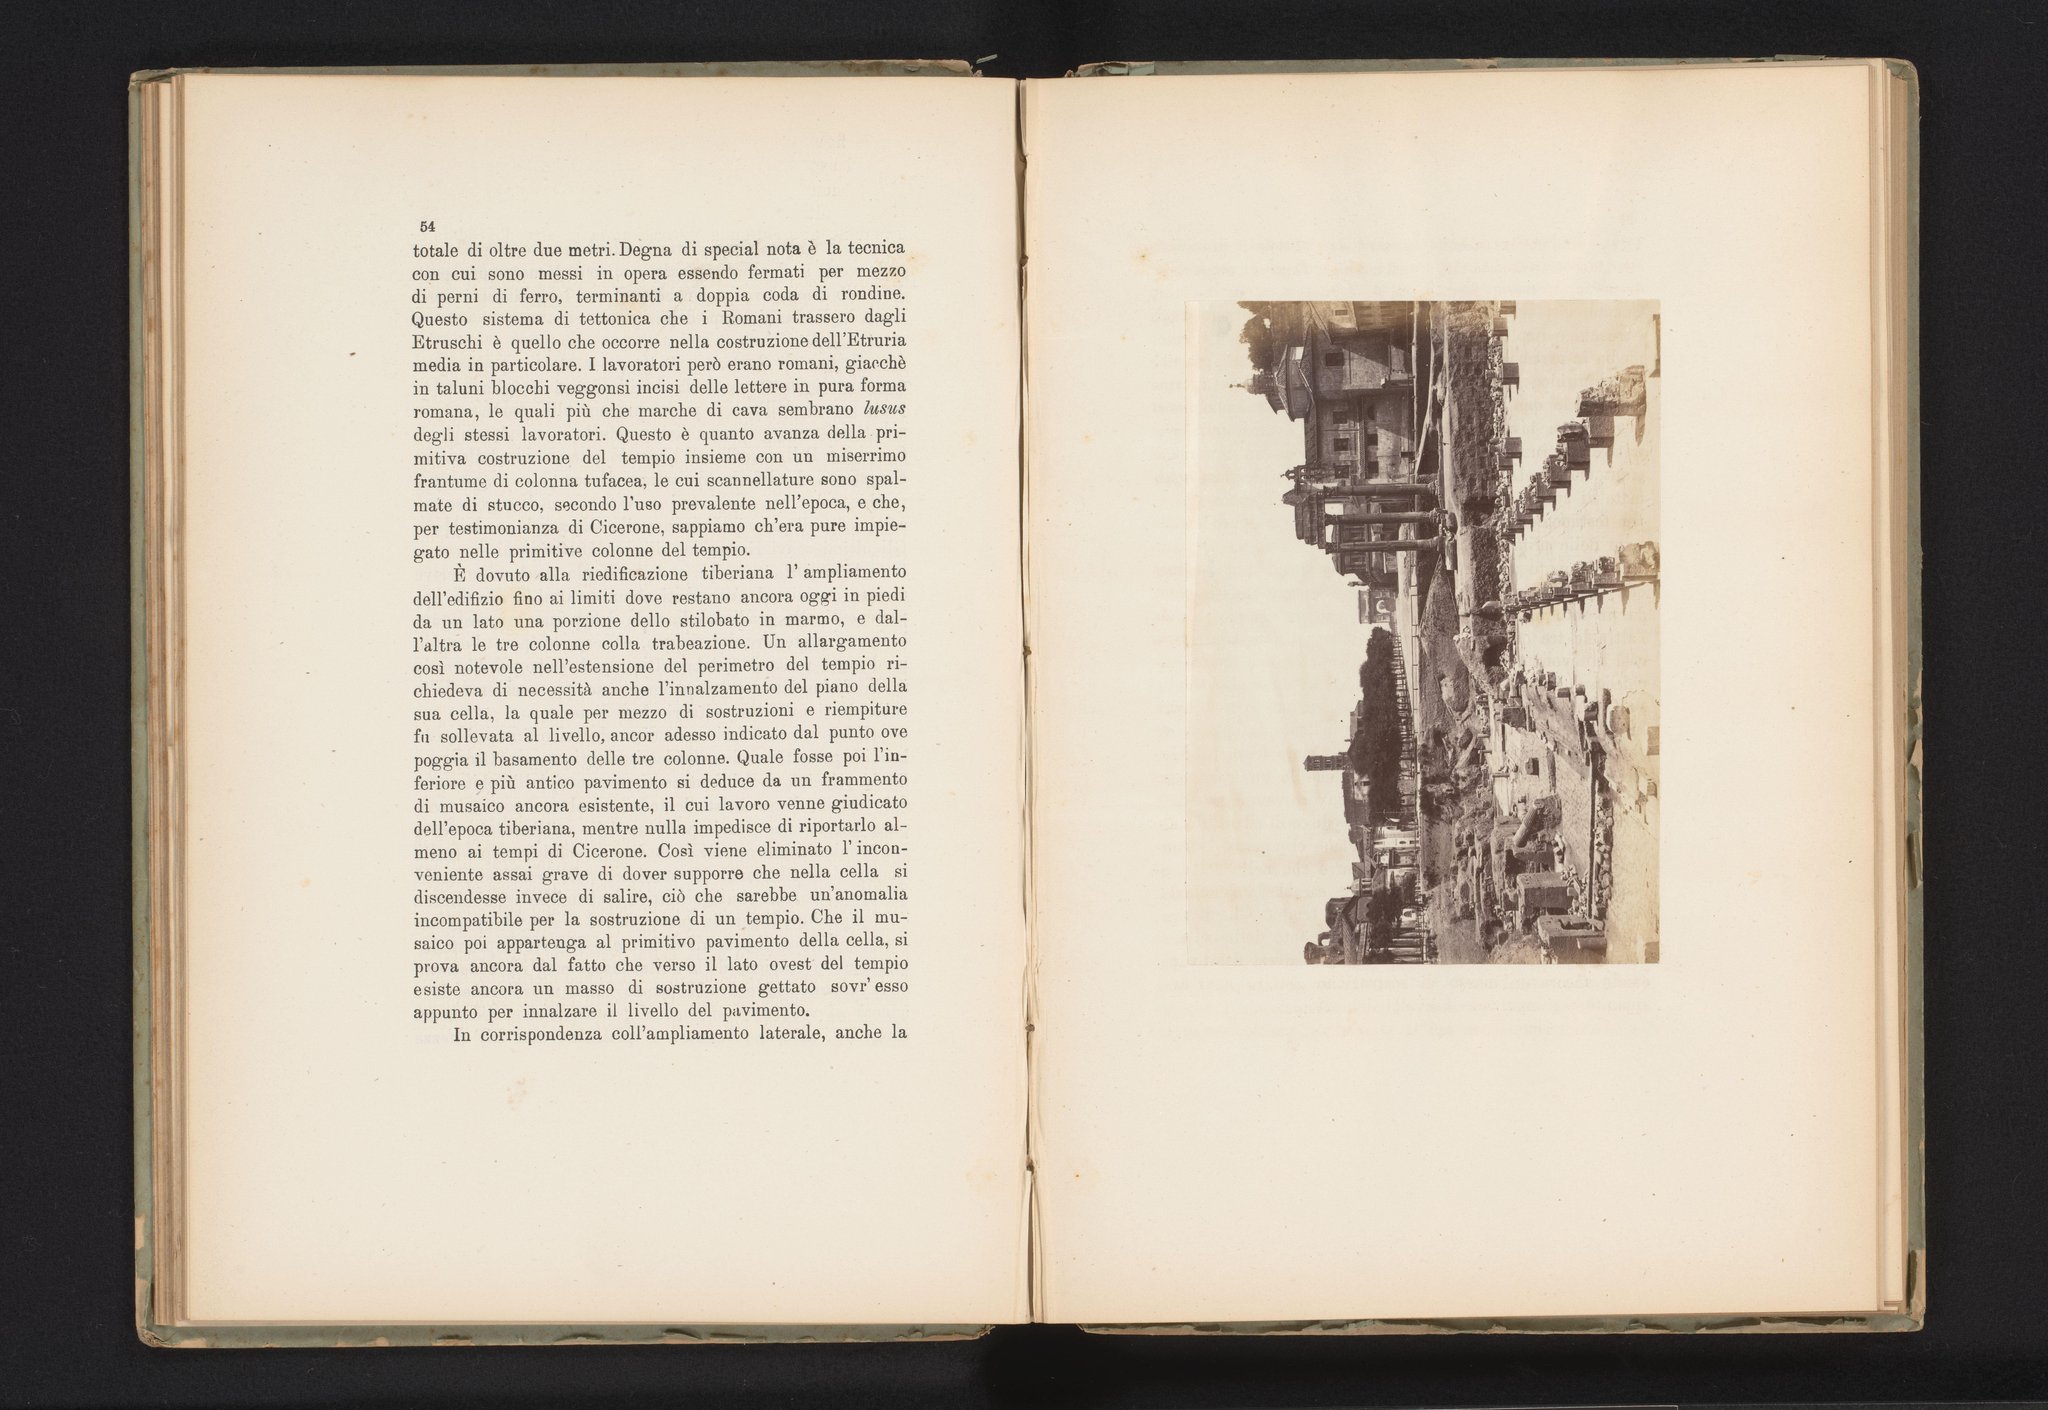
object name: photograph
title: Gezicht op de ruïne van de Basilica Julia op het Forum Romanum te Rome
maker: Anonymous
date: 1863-1873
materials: photographic support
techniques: albumen print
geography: forum romanum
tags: ruin of a building ~ architecture